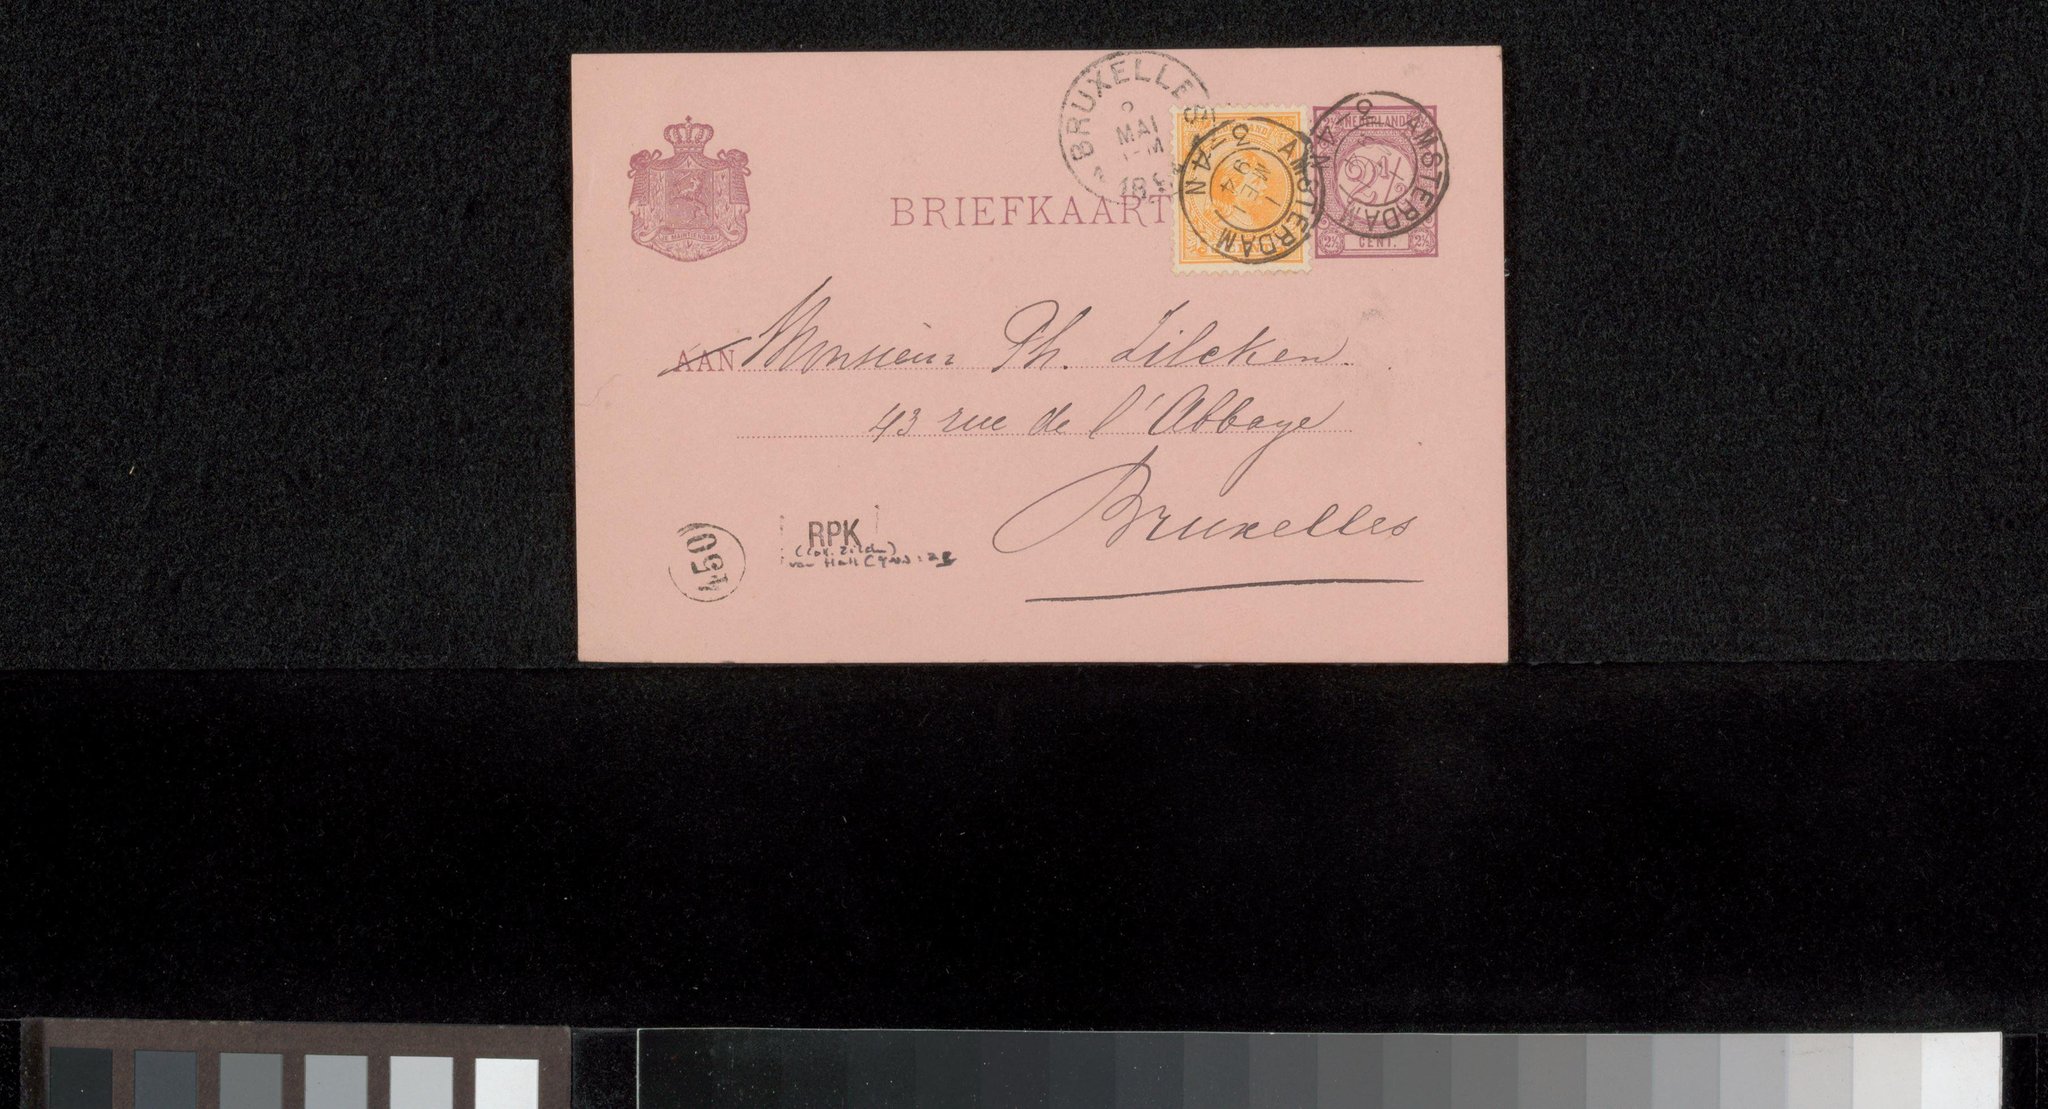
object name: postcard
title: Briefkaart aan Philip Zilcken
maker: jacob nicolaas van hall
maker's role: politician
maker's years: 1840-1918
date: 1894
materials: cardboard, ink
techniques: pen, writing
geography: amsterdam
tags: max rooses, the hague, painter, philip zilcken, exhibition ~ art, antwerp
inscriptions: collector's mark: ‘RPK’